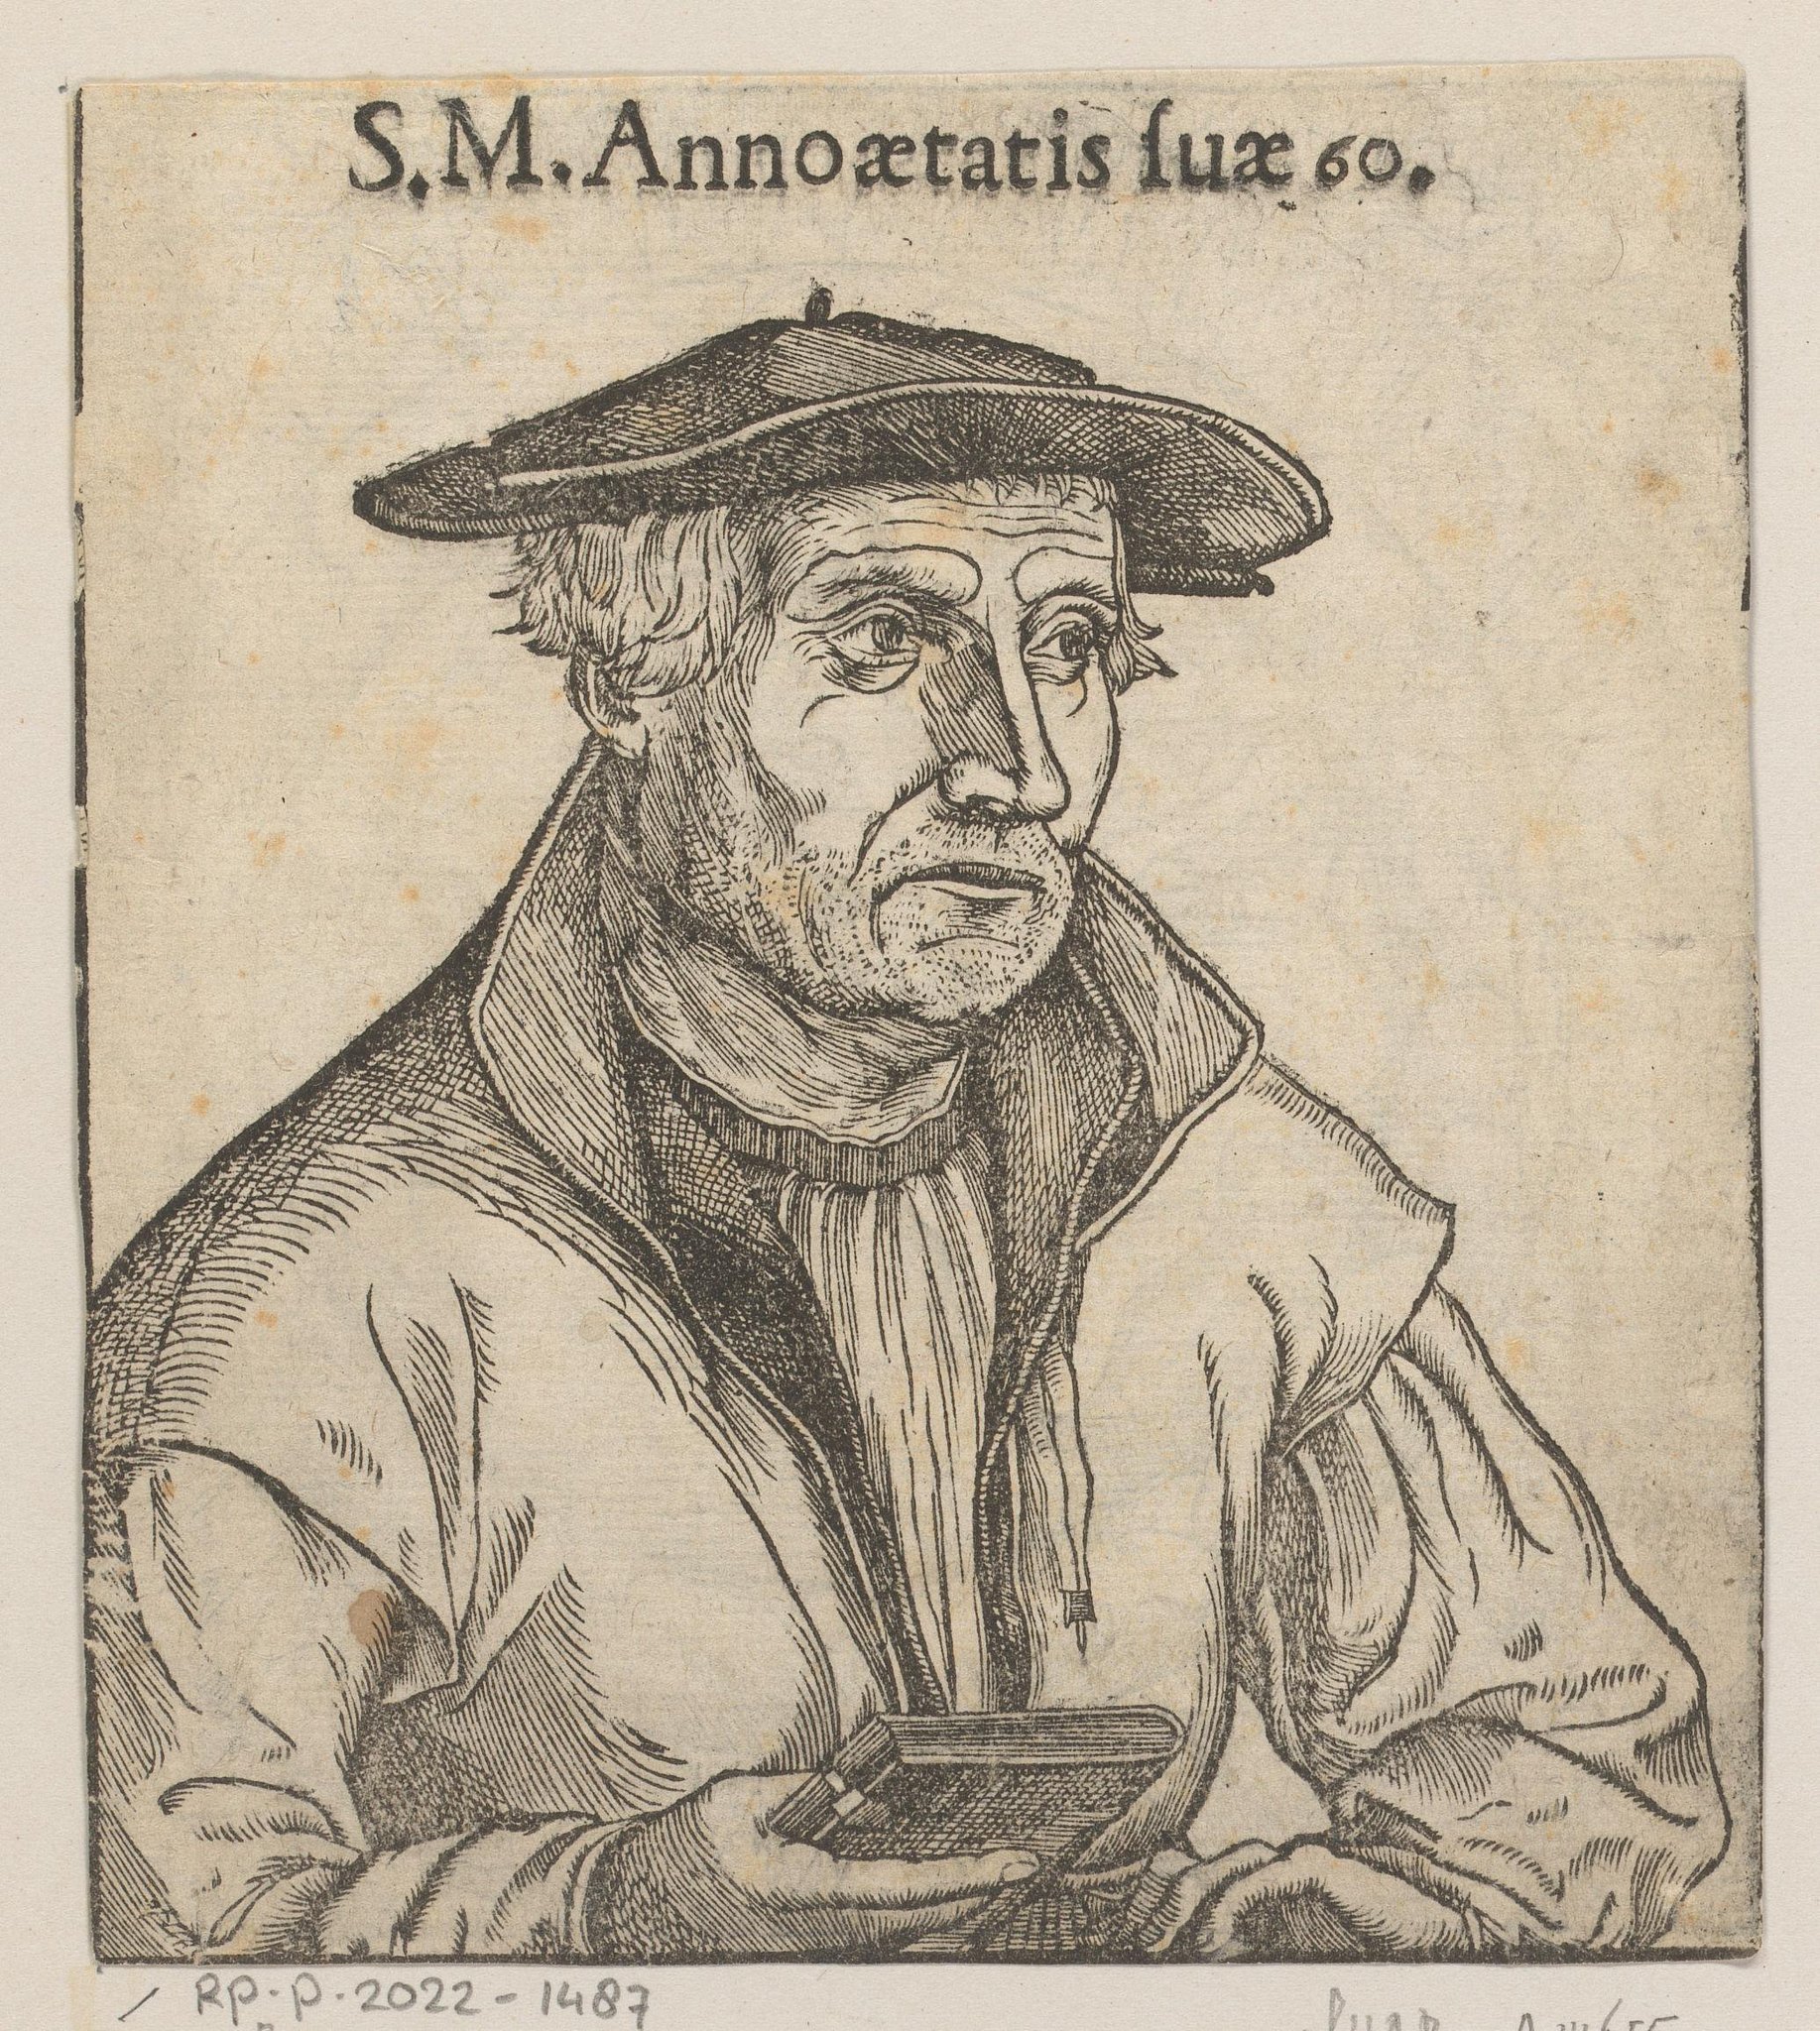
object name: book illustration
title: S.M. Anno aetatis suae 60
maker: Anonymous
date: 1544-1600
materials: paper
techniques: letterpress printing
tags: scholar, philosopher, historical persons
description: Prent waarschijnlijk uit een deel van: Münster, Sebastian. Cosmographiae uniuersalis (...). Bazel: Heinrich Petri.